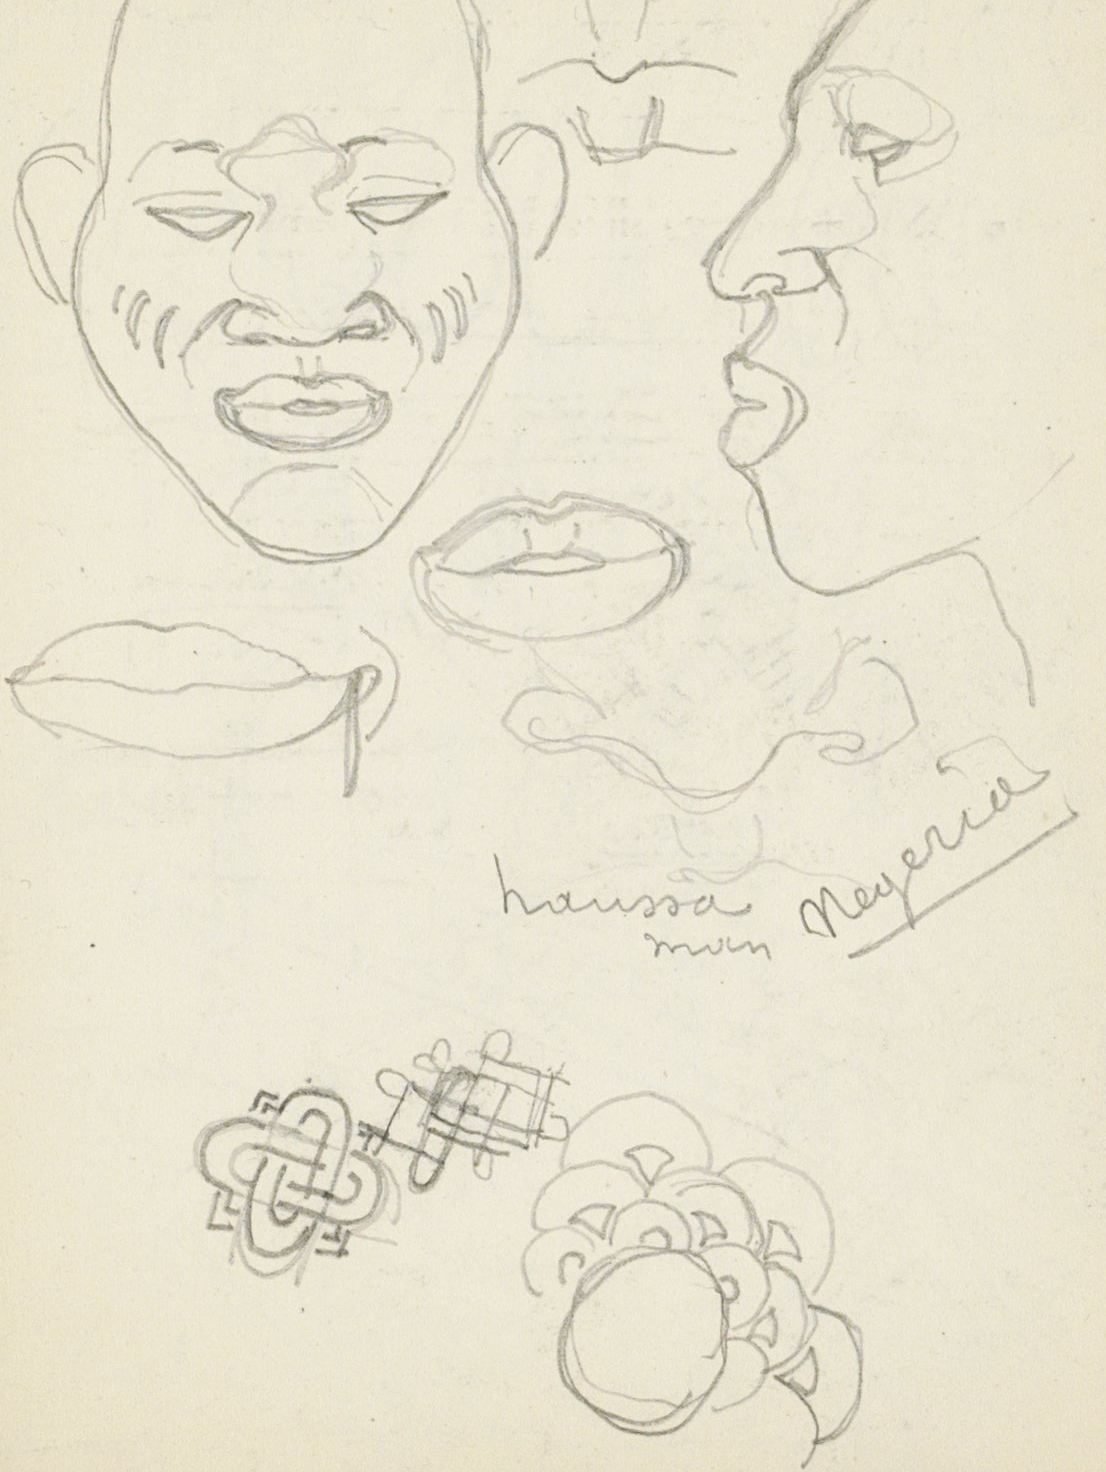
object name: sketchbook leaf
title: Hoofden van de Hausa te Nigeria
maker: reijer stolk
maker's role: draughtsman, print maker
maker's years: 1896-1945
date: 1916-1945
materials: paper, pencil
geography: nigeria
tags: head (human), africans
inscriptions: annotation: ‘haussa/ mam/ Nigeria’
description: Tevens studies van lippen, een neus en decoratieve motieven. Blad 49 recto uit een schetsboek met 60 bladen.